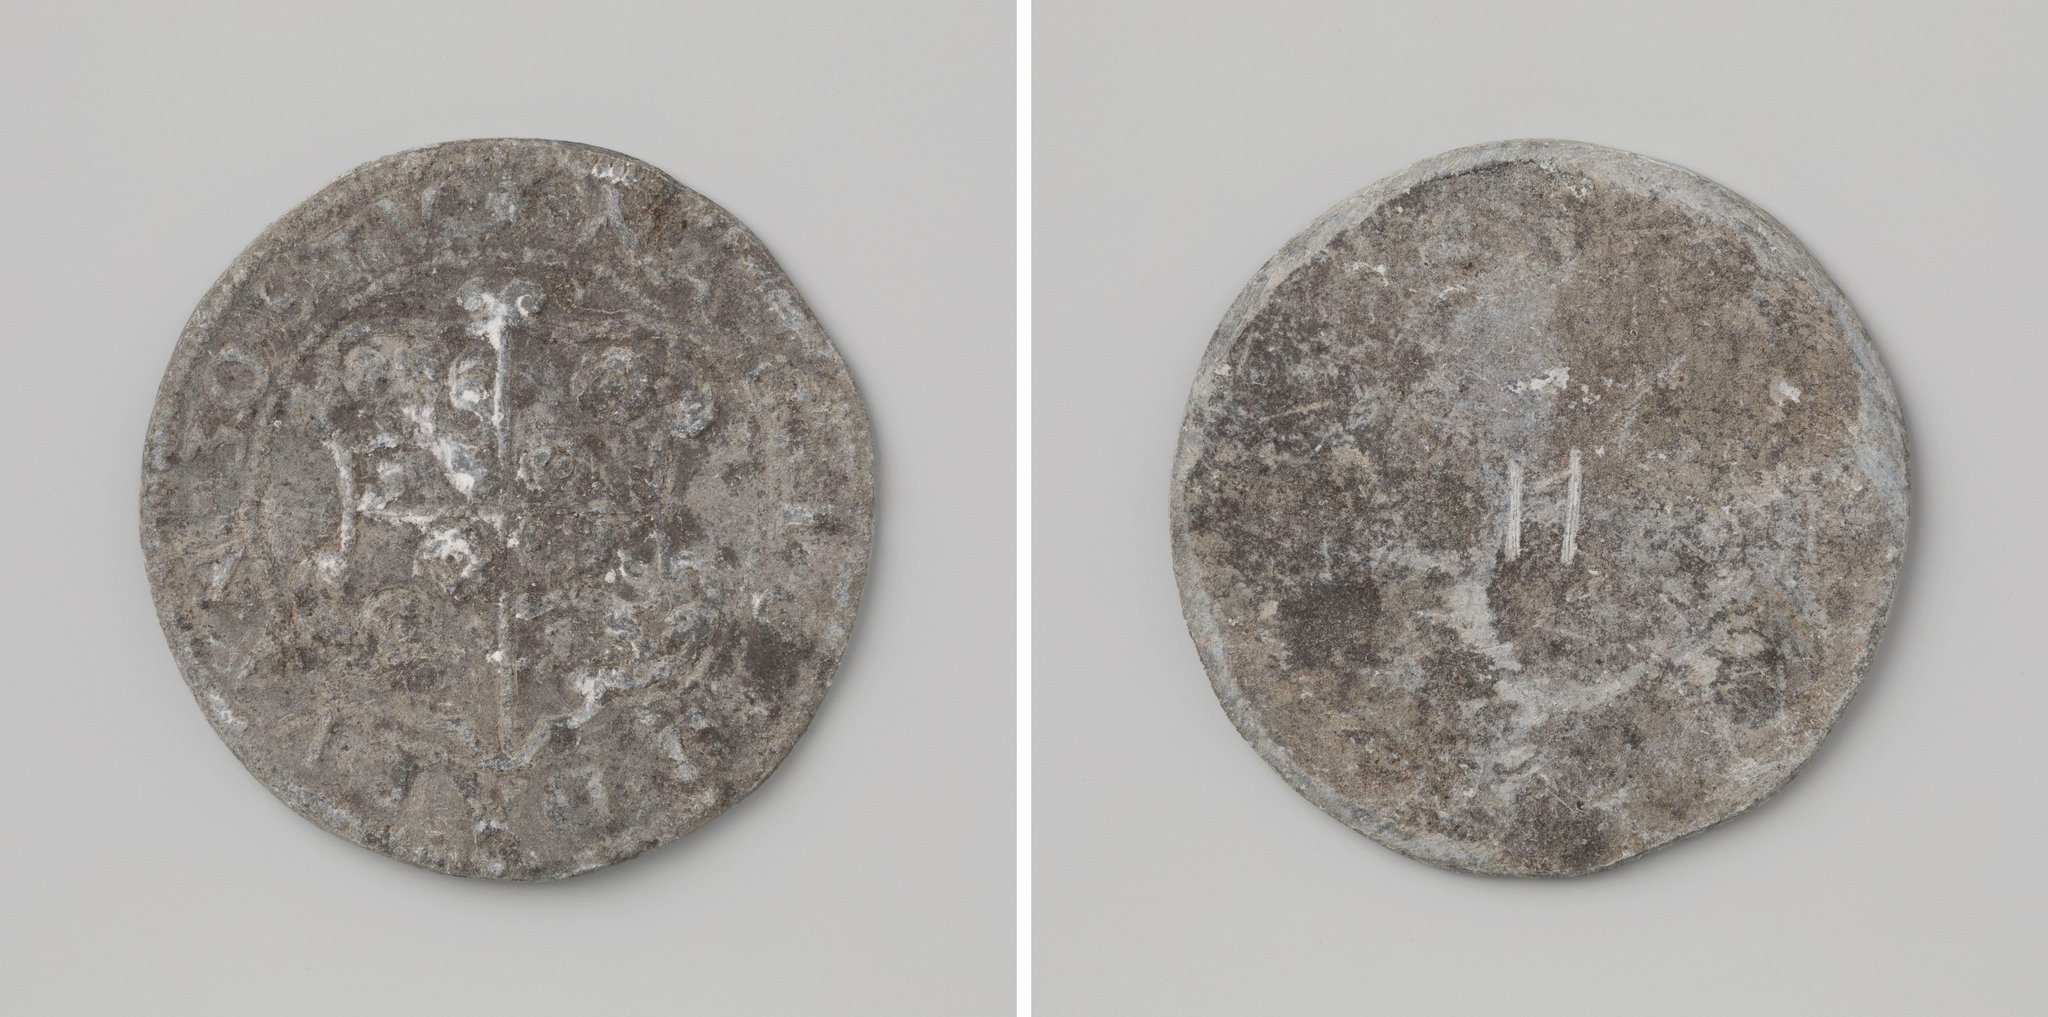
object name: coin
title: Afslag in lood van de keerzijde van een daalder van 30 stuiver van de stad Zaltbommel, 1582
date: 1582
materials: lead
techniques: striking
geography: zaltbommel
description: Loden afslag van een zilveren munt. Keerzijde: gevierendeeld wapenschild van de stad. In omschrift waarde-aanduiding: rozet NA GEL ORD DAL VAN 30 STV. Afslag in lood, vervaardigd met in Zaltbommel nog aanwezig stempel van de keerzijde.